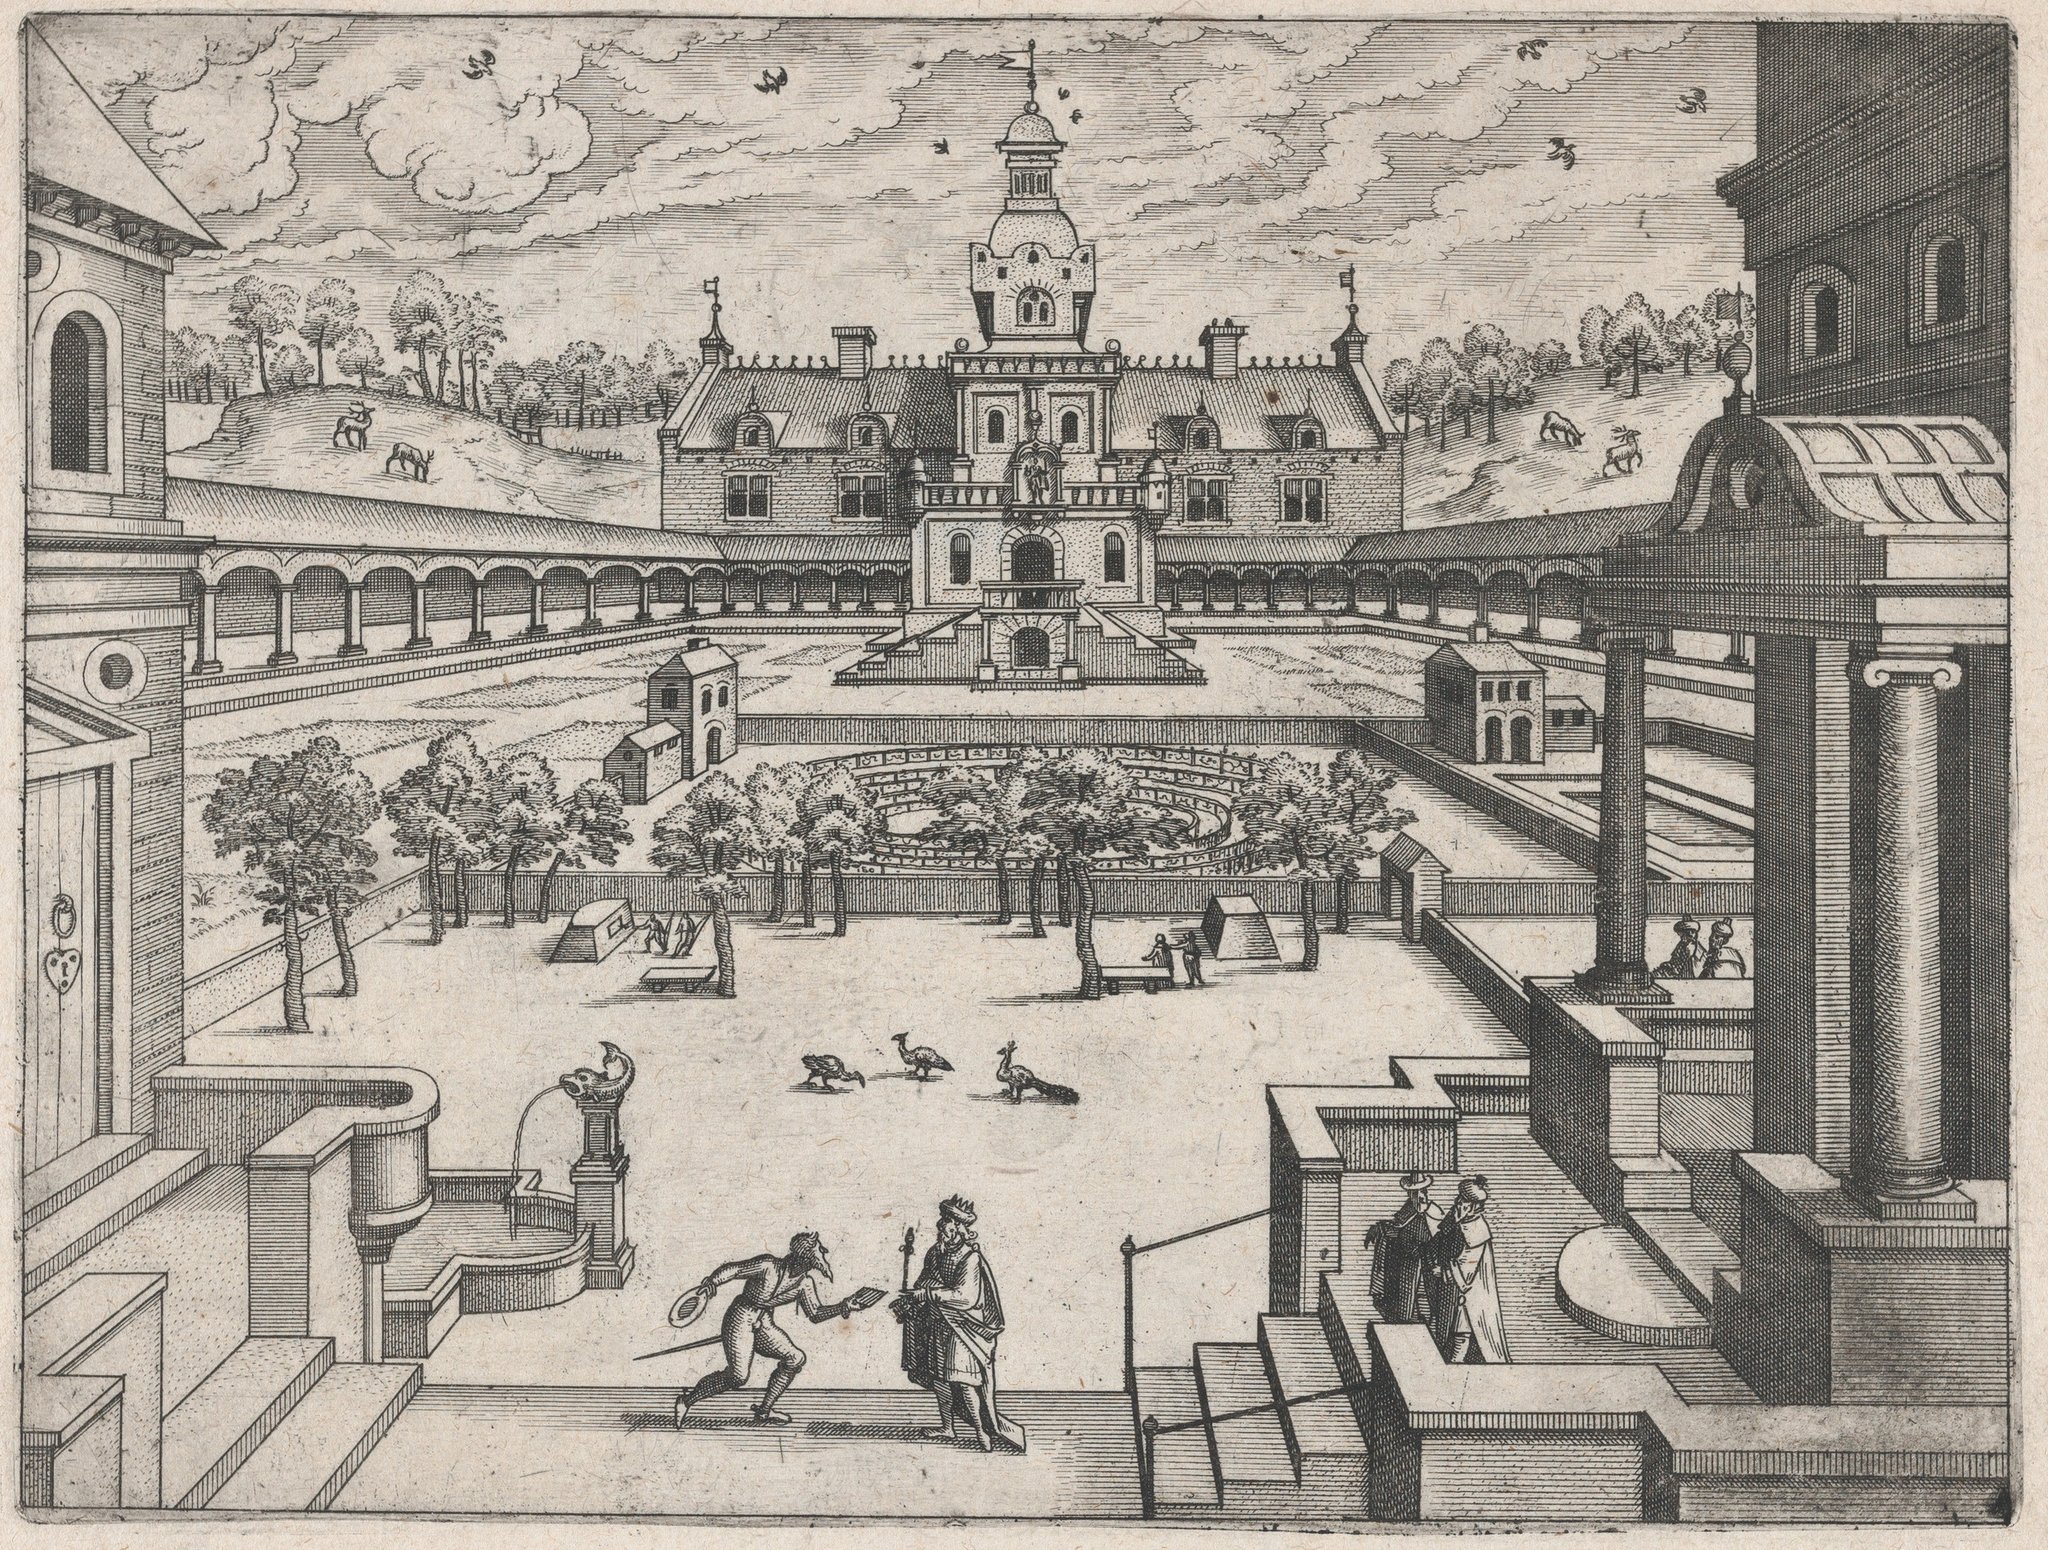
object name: print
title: Walled Garden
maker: lucas gassel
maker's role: artist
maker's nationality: netherlandish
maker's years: 1495-1500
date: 1560-1570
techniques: engraving, etching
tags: gardens,men